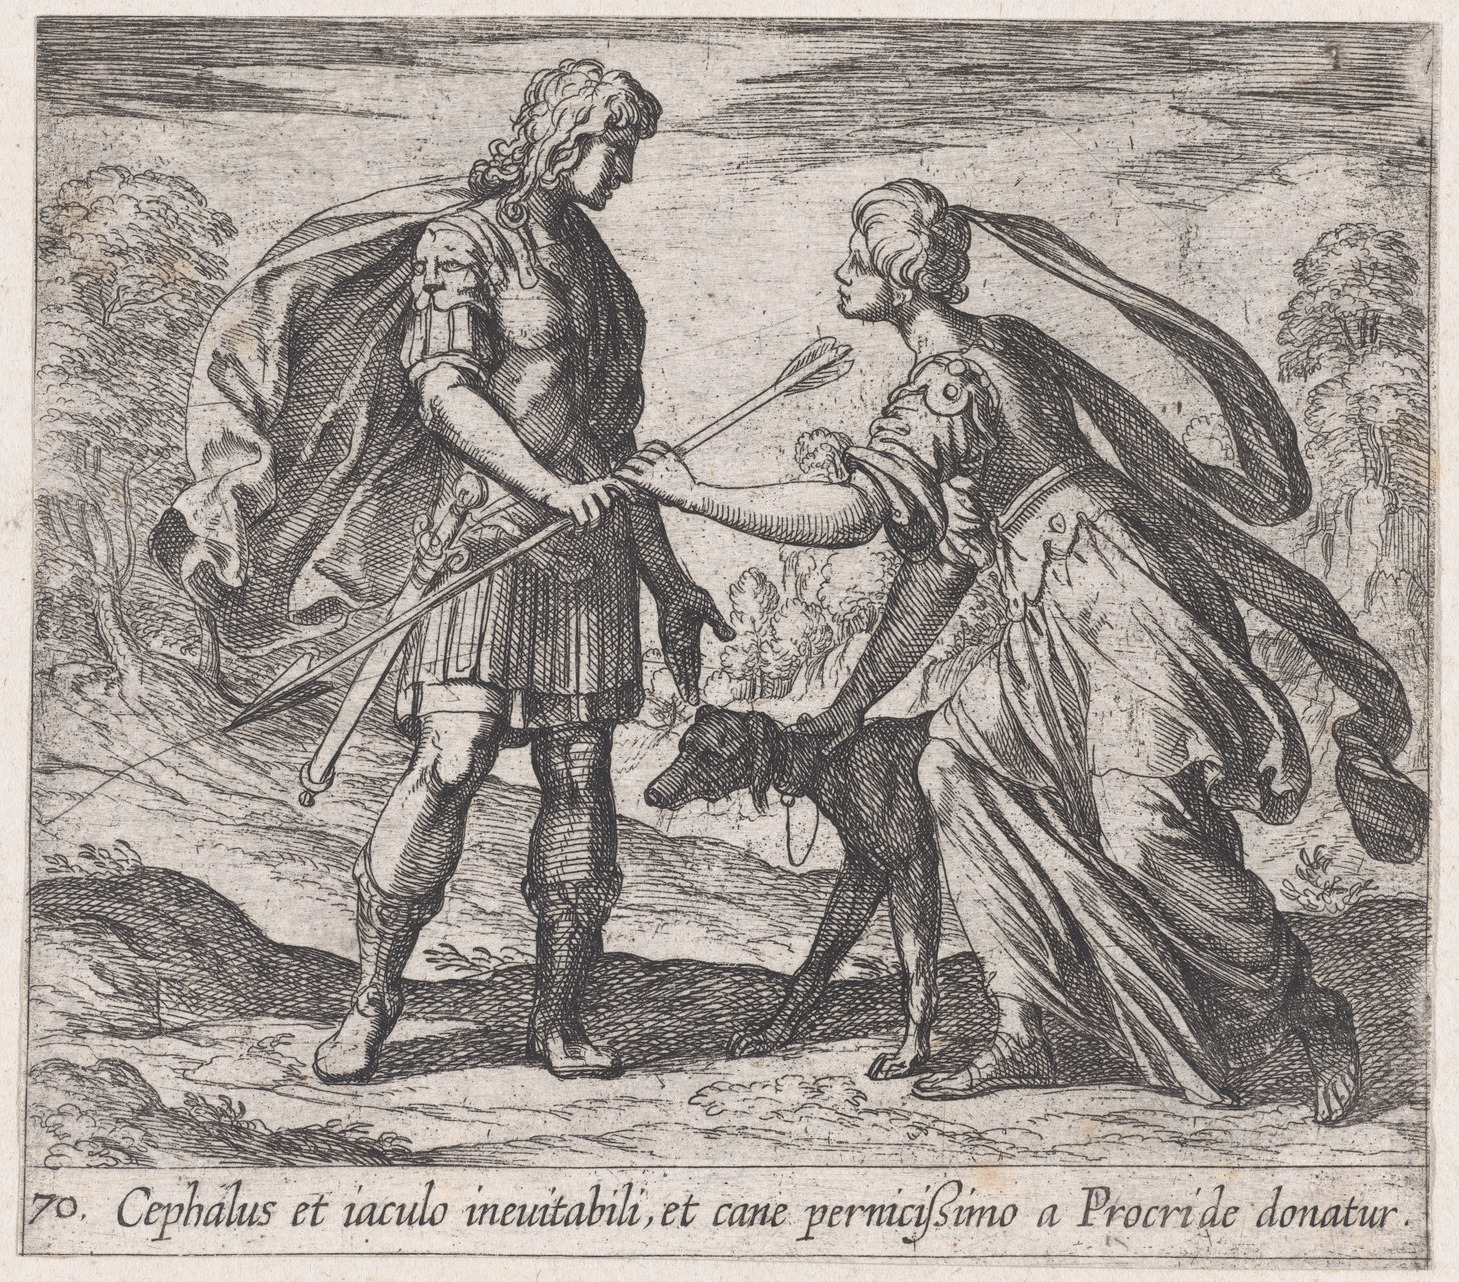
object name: print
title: Pltae 70: Procris Giving Cephalus a Dog and a Javelin (Cephalus et iaculo inevitabili, et cane pernicißimo a Procride donatur), from Ovid's 'Metamorphoses'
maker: antonio tempesta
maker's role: artist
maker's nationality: italian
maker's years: 1555-1630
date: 1606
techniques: etching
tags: men,women,dogs